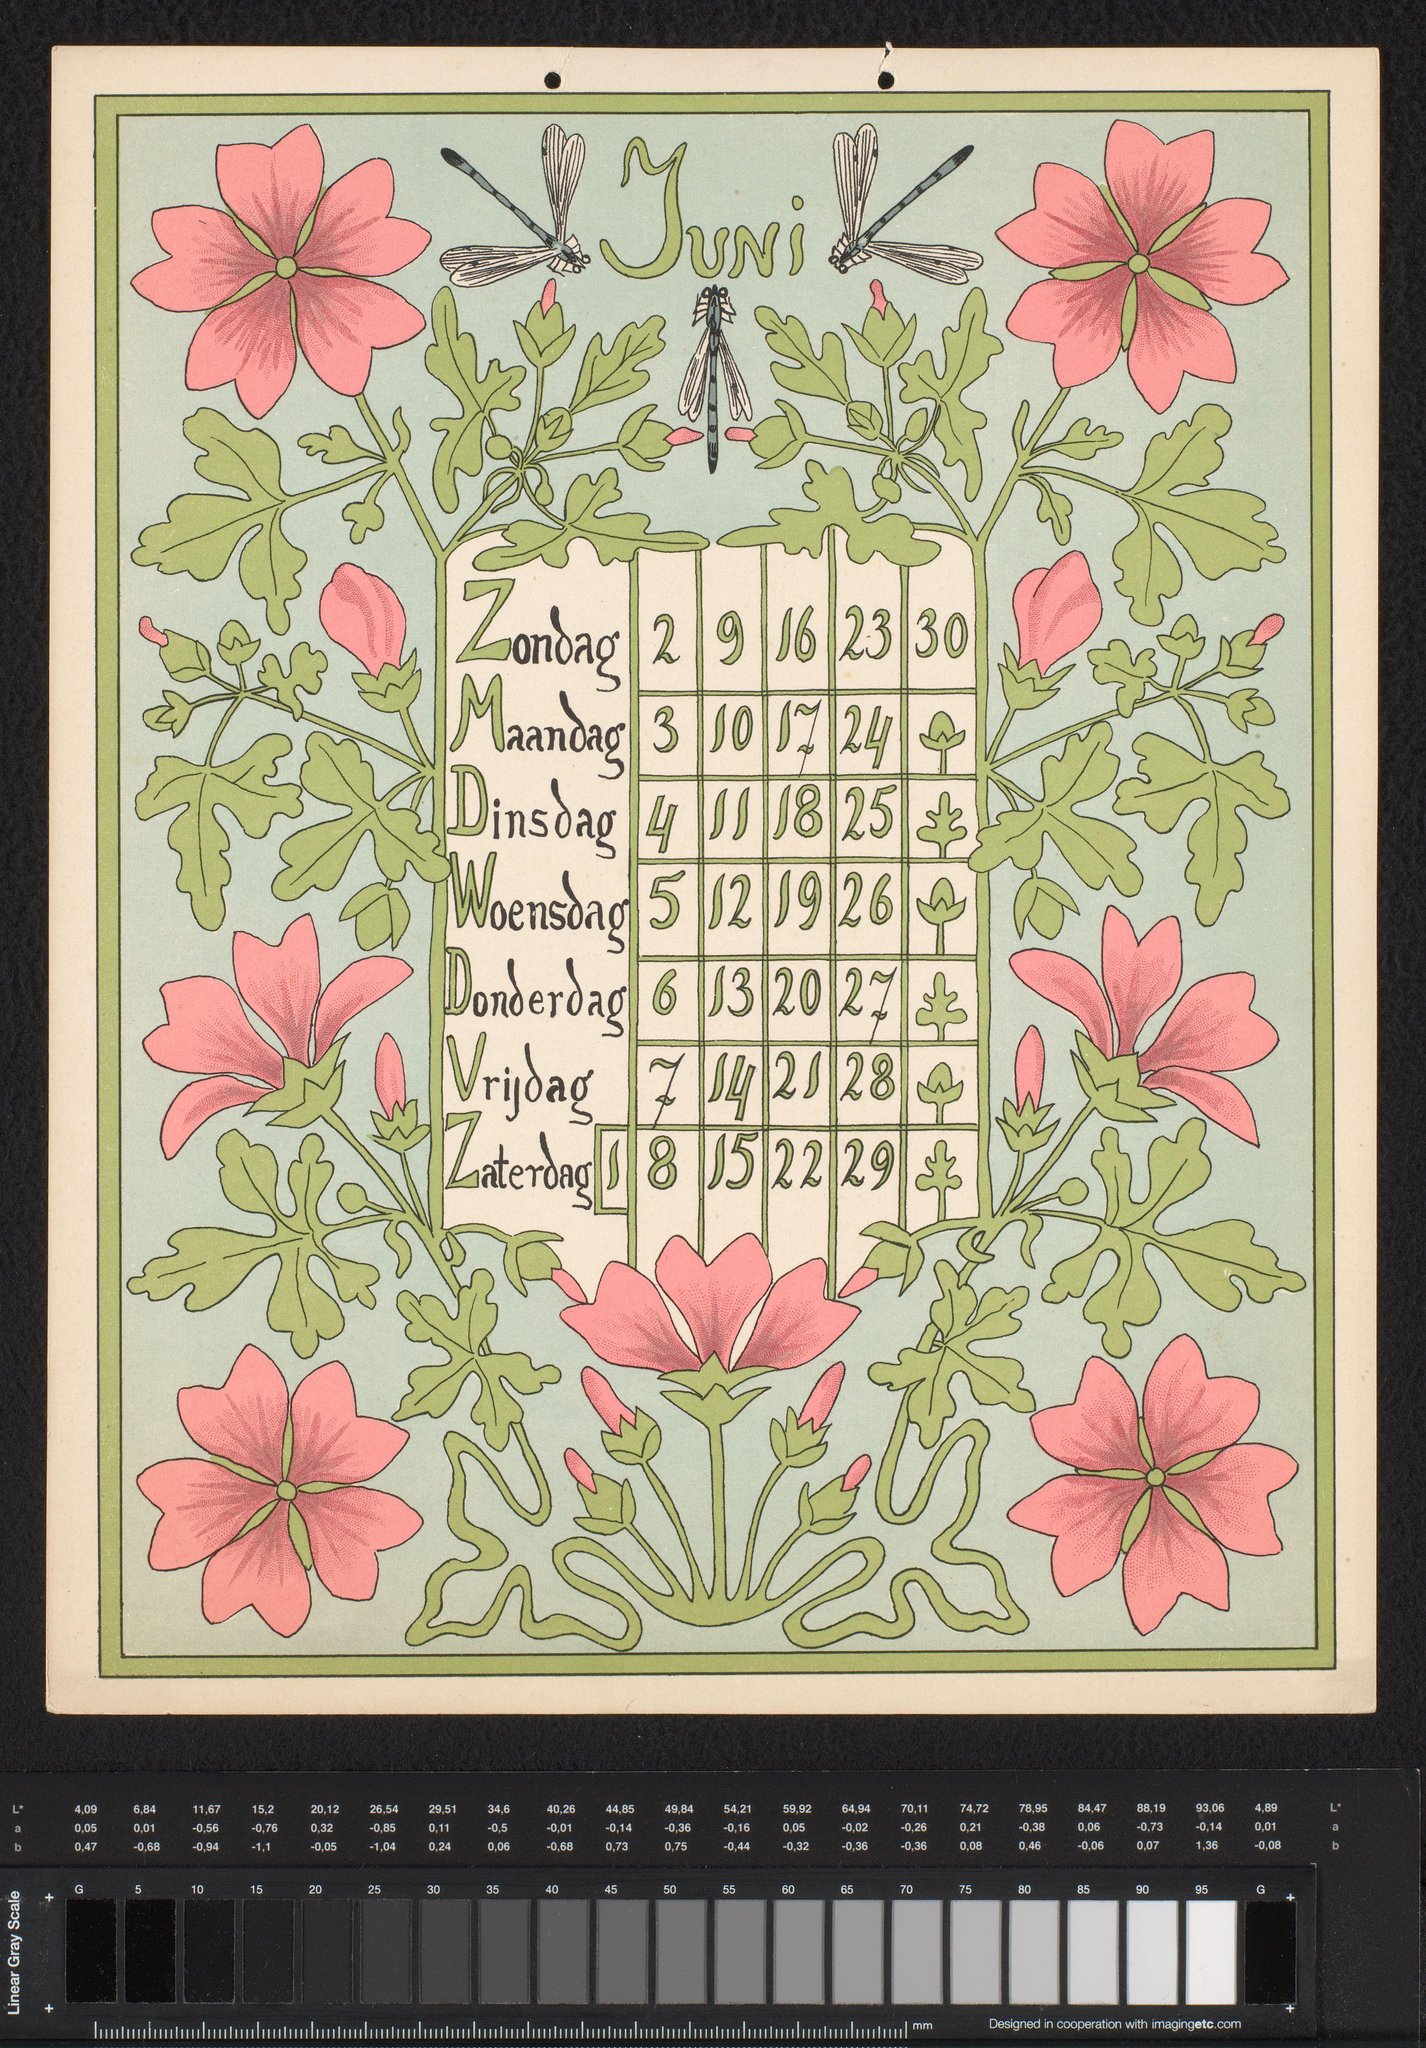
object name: calendar leaf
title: Kalenderblad voor juni 1901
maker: c.a.j. van dishoeck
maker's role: publisher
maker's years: 1863-1931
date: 1900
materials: paper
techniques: lithograph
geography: amsterdam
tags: flowers, ornaments ~ art, calendar, almanac, insects: dragon-fly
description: Kalenderblad voor juni 1901 van de kalender 'Bloem en Blad', met een randdecoratie van bloemen en libellen.